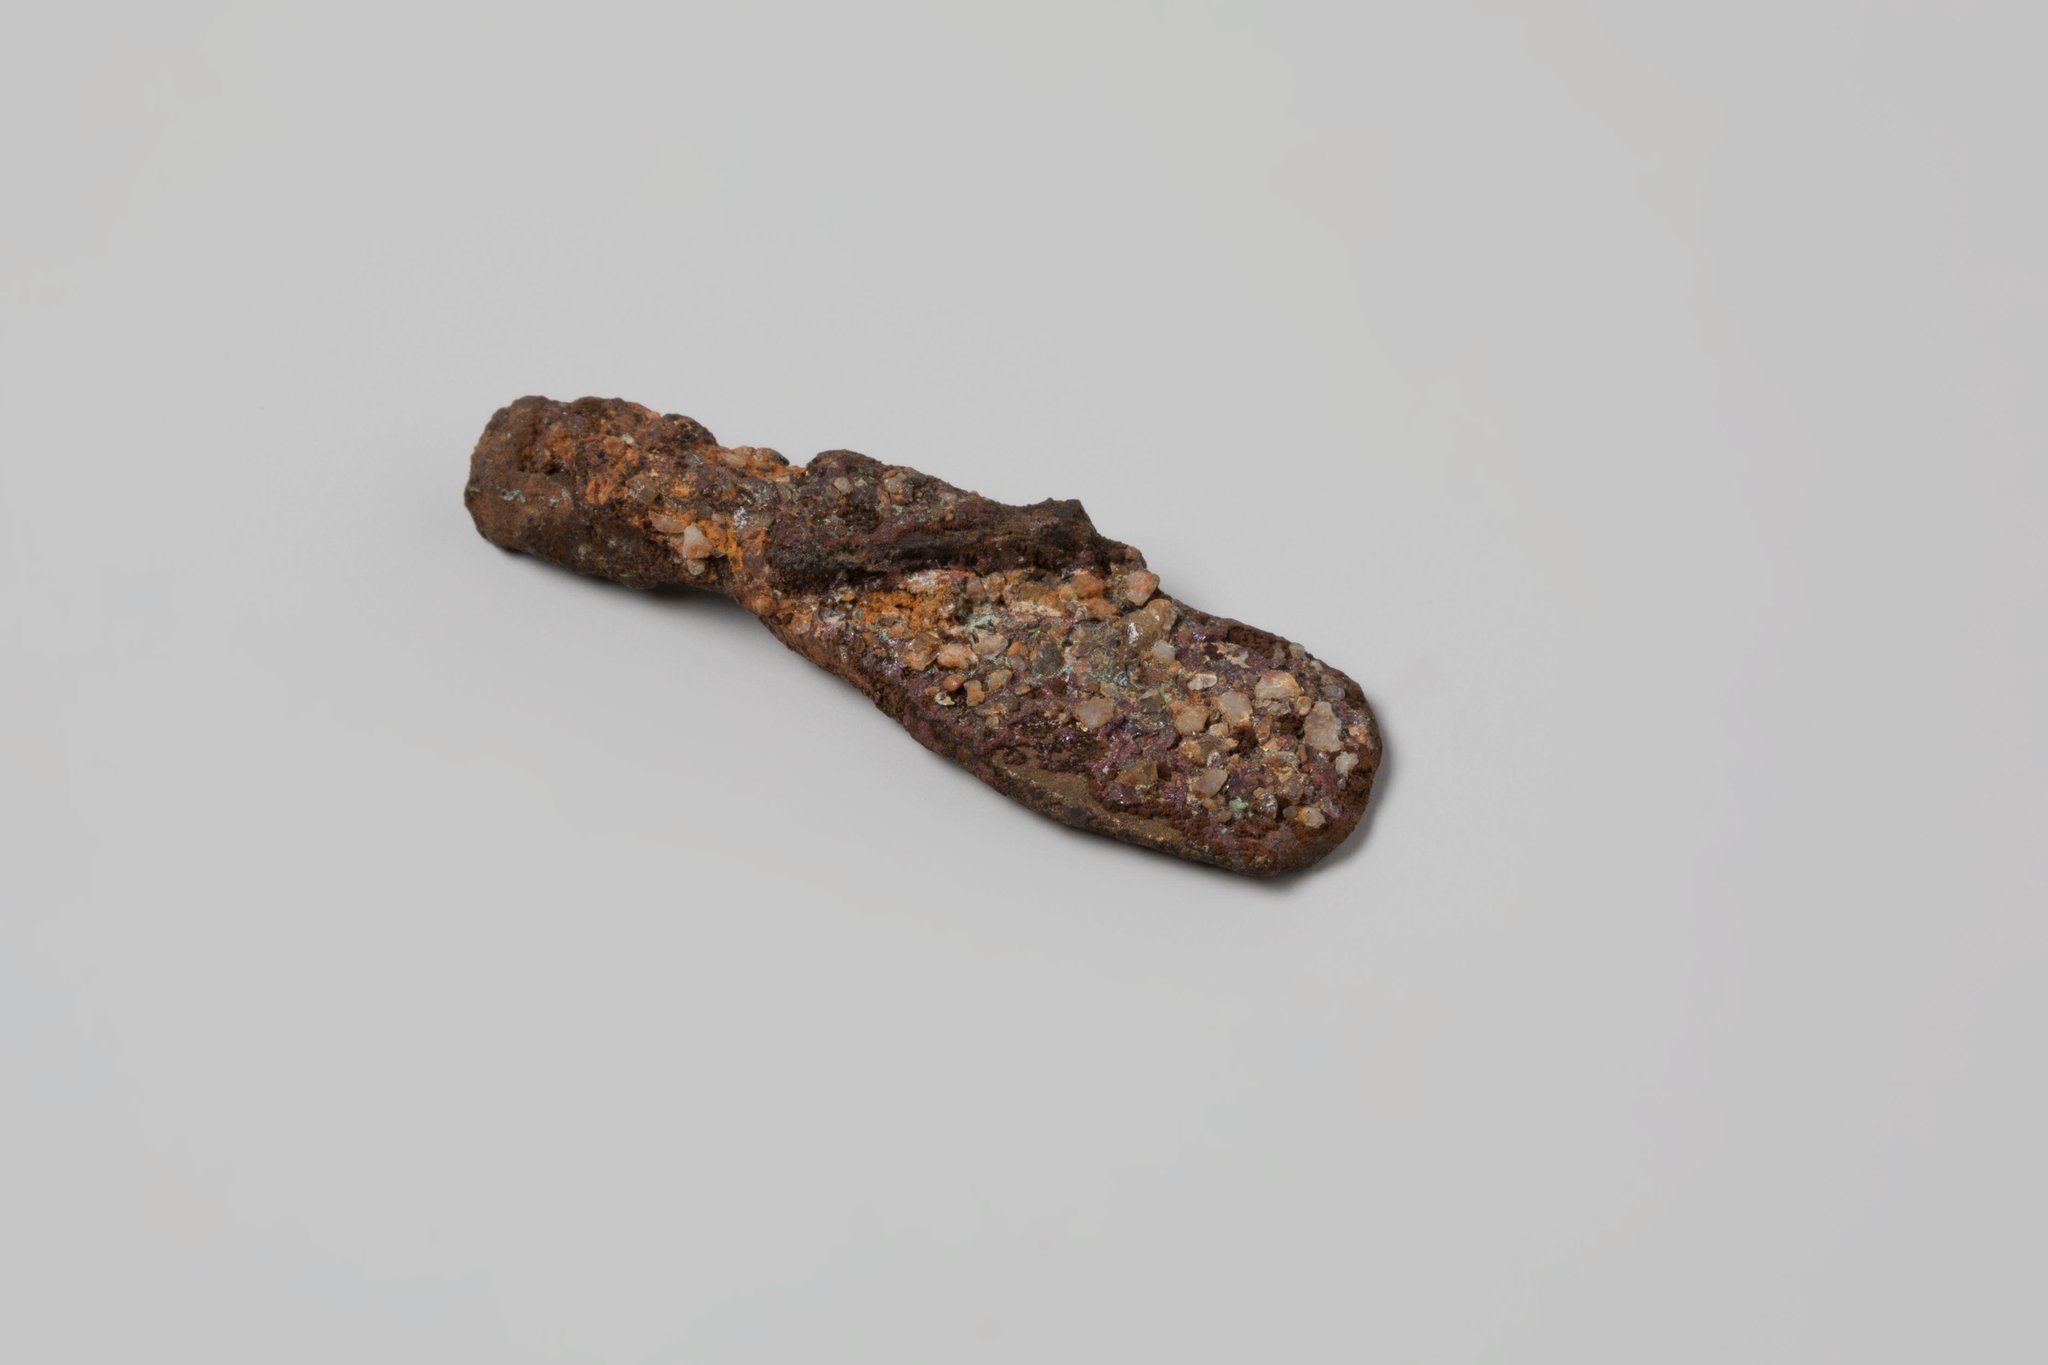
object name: pin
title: fragment speld uit het wrak van de Oost-Indiëvaarder Hollandia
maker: Anonymous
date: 1700-1743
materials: copper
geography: netherlands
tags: verenigde oostindische compagnie, hollandia (schip), annet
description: Tools and instruments, sewing and sailmaking, pin; fragm of shaft, id. NG 1980-27H3265, concreted.